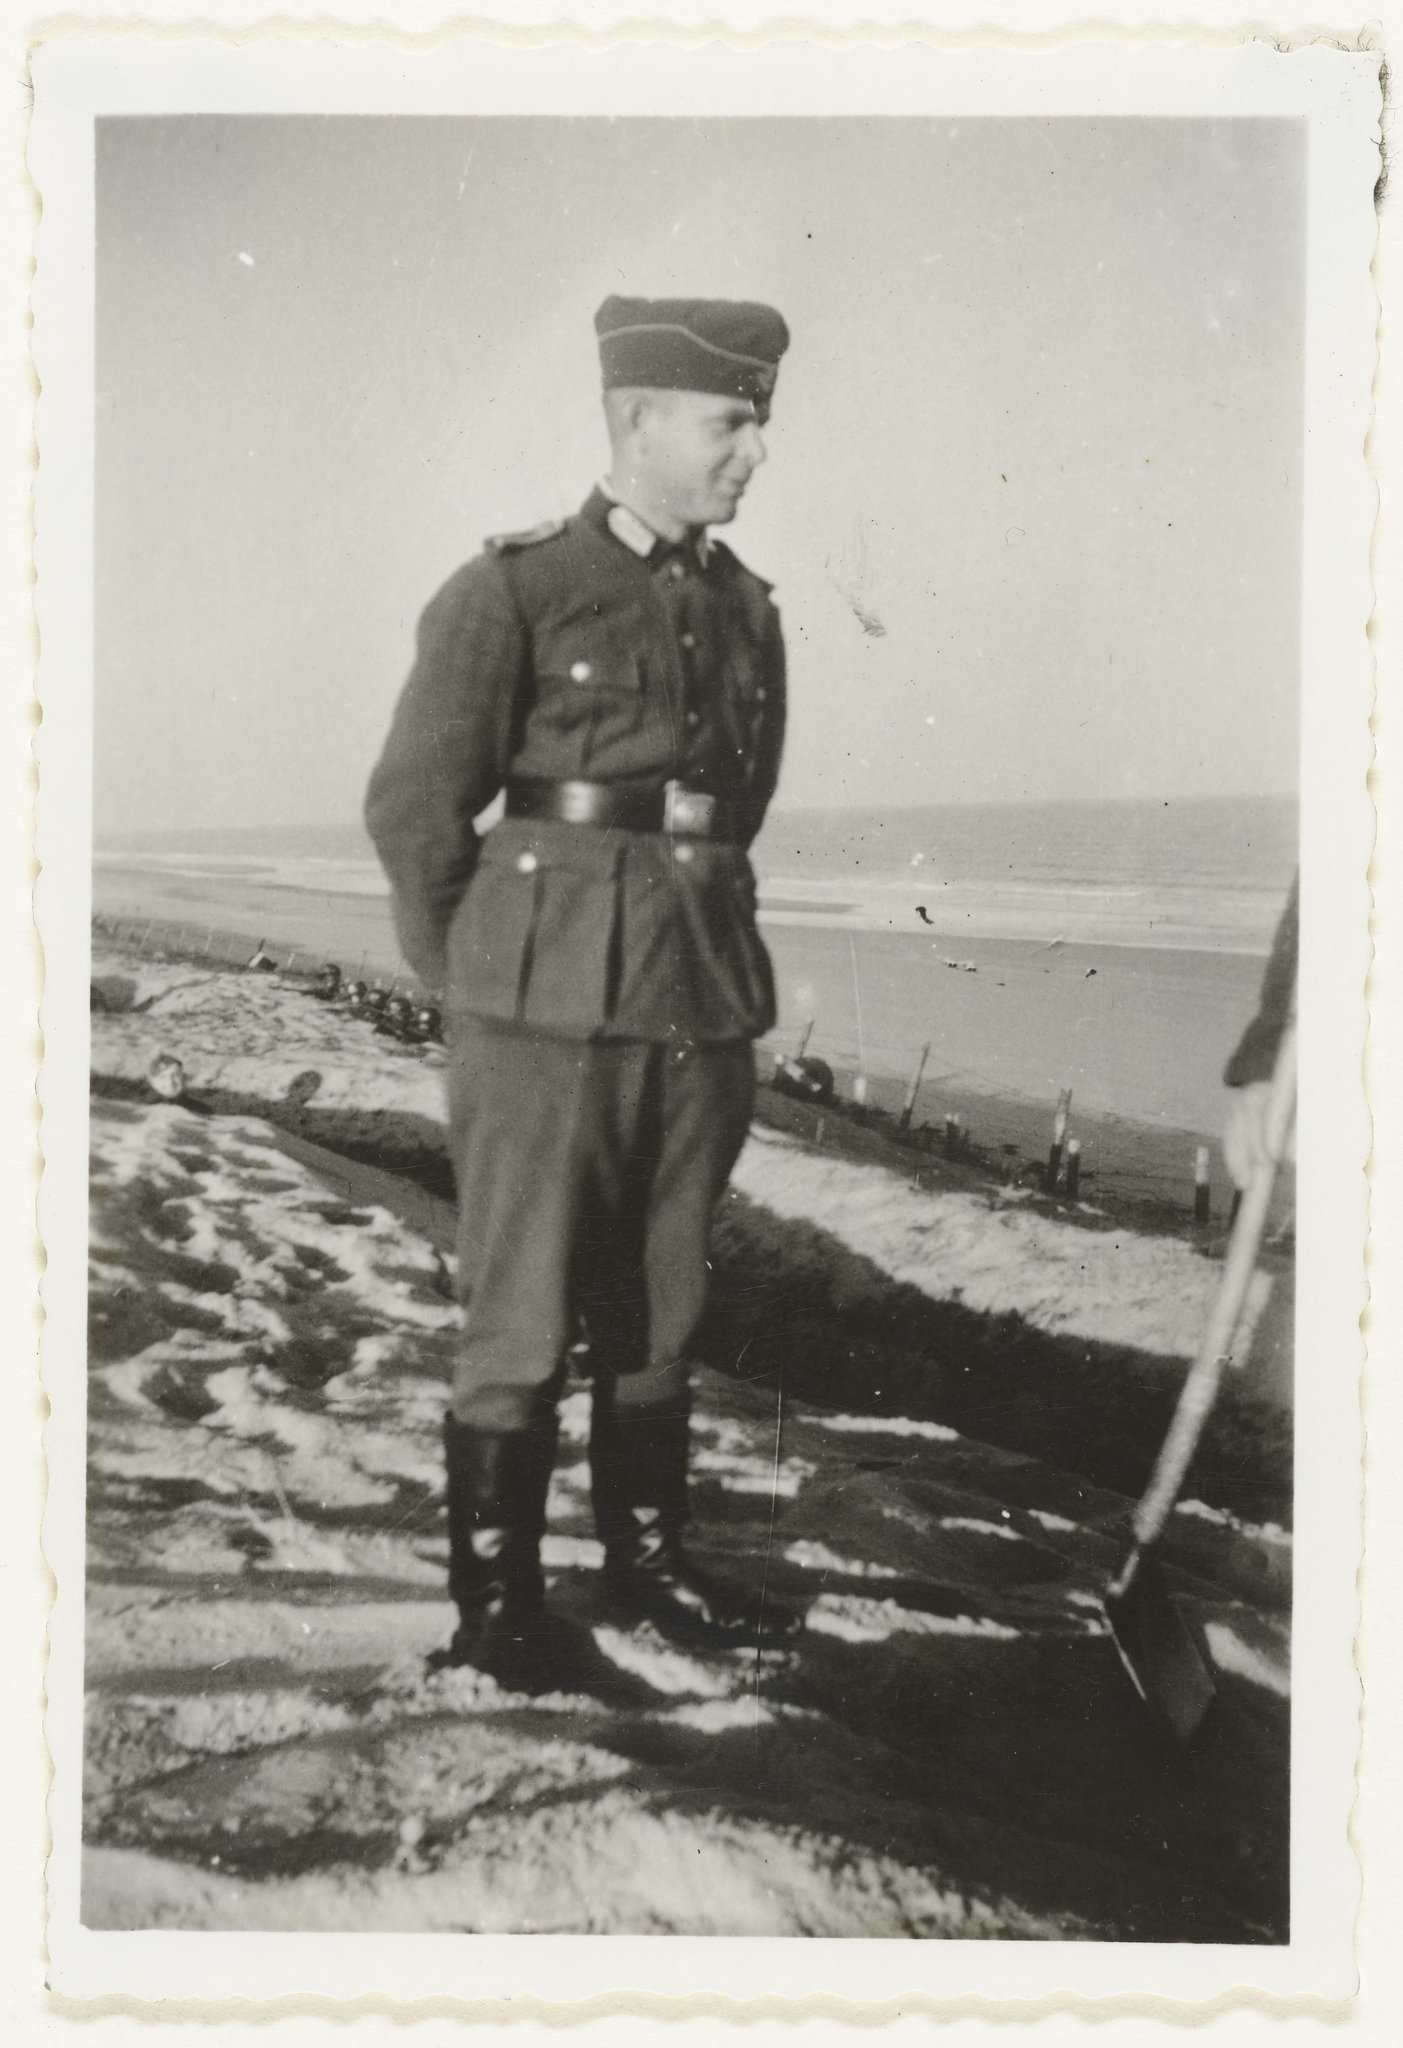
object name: photograph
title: Wehrmacht militair aan het strand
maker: Anonymous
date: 1941-1942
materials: photographic support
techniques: gelatin silver print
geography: netherlands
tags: fortifications, military engineering, occupation ~ war, netherlands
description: Een Wehrmacht militair staat op een duin dicht bij het strand, rechts van hem staat iemand met een schep. Op het strand zijn mensen bezig iets aan te leggen. Vermoedelijk staat het in verband met de Atlantikwall, in ieder geval met versperringen aan de kust. Achterop staat: Ufm. Coordes